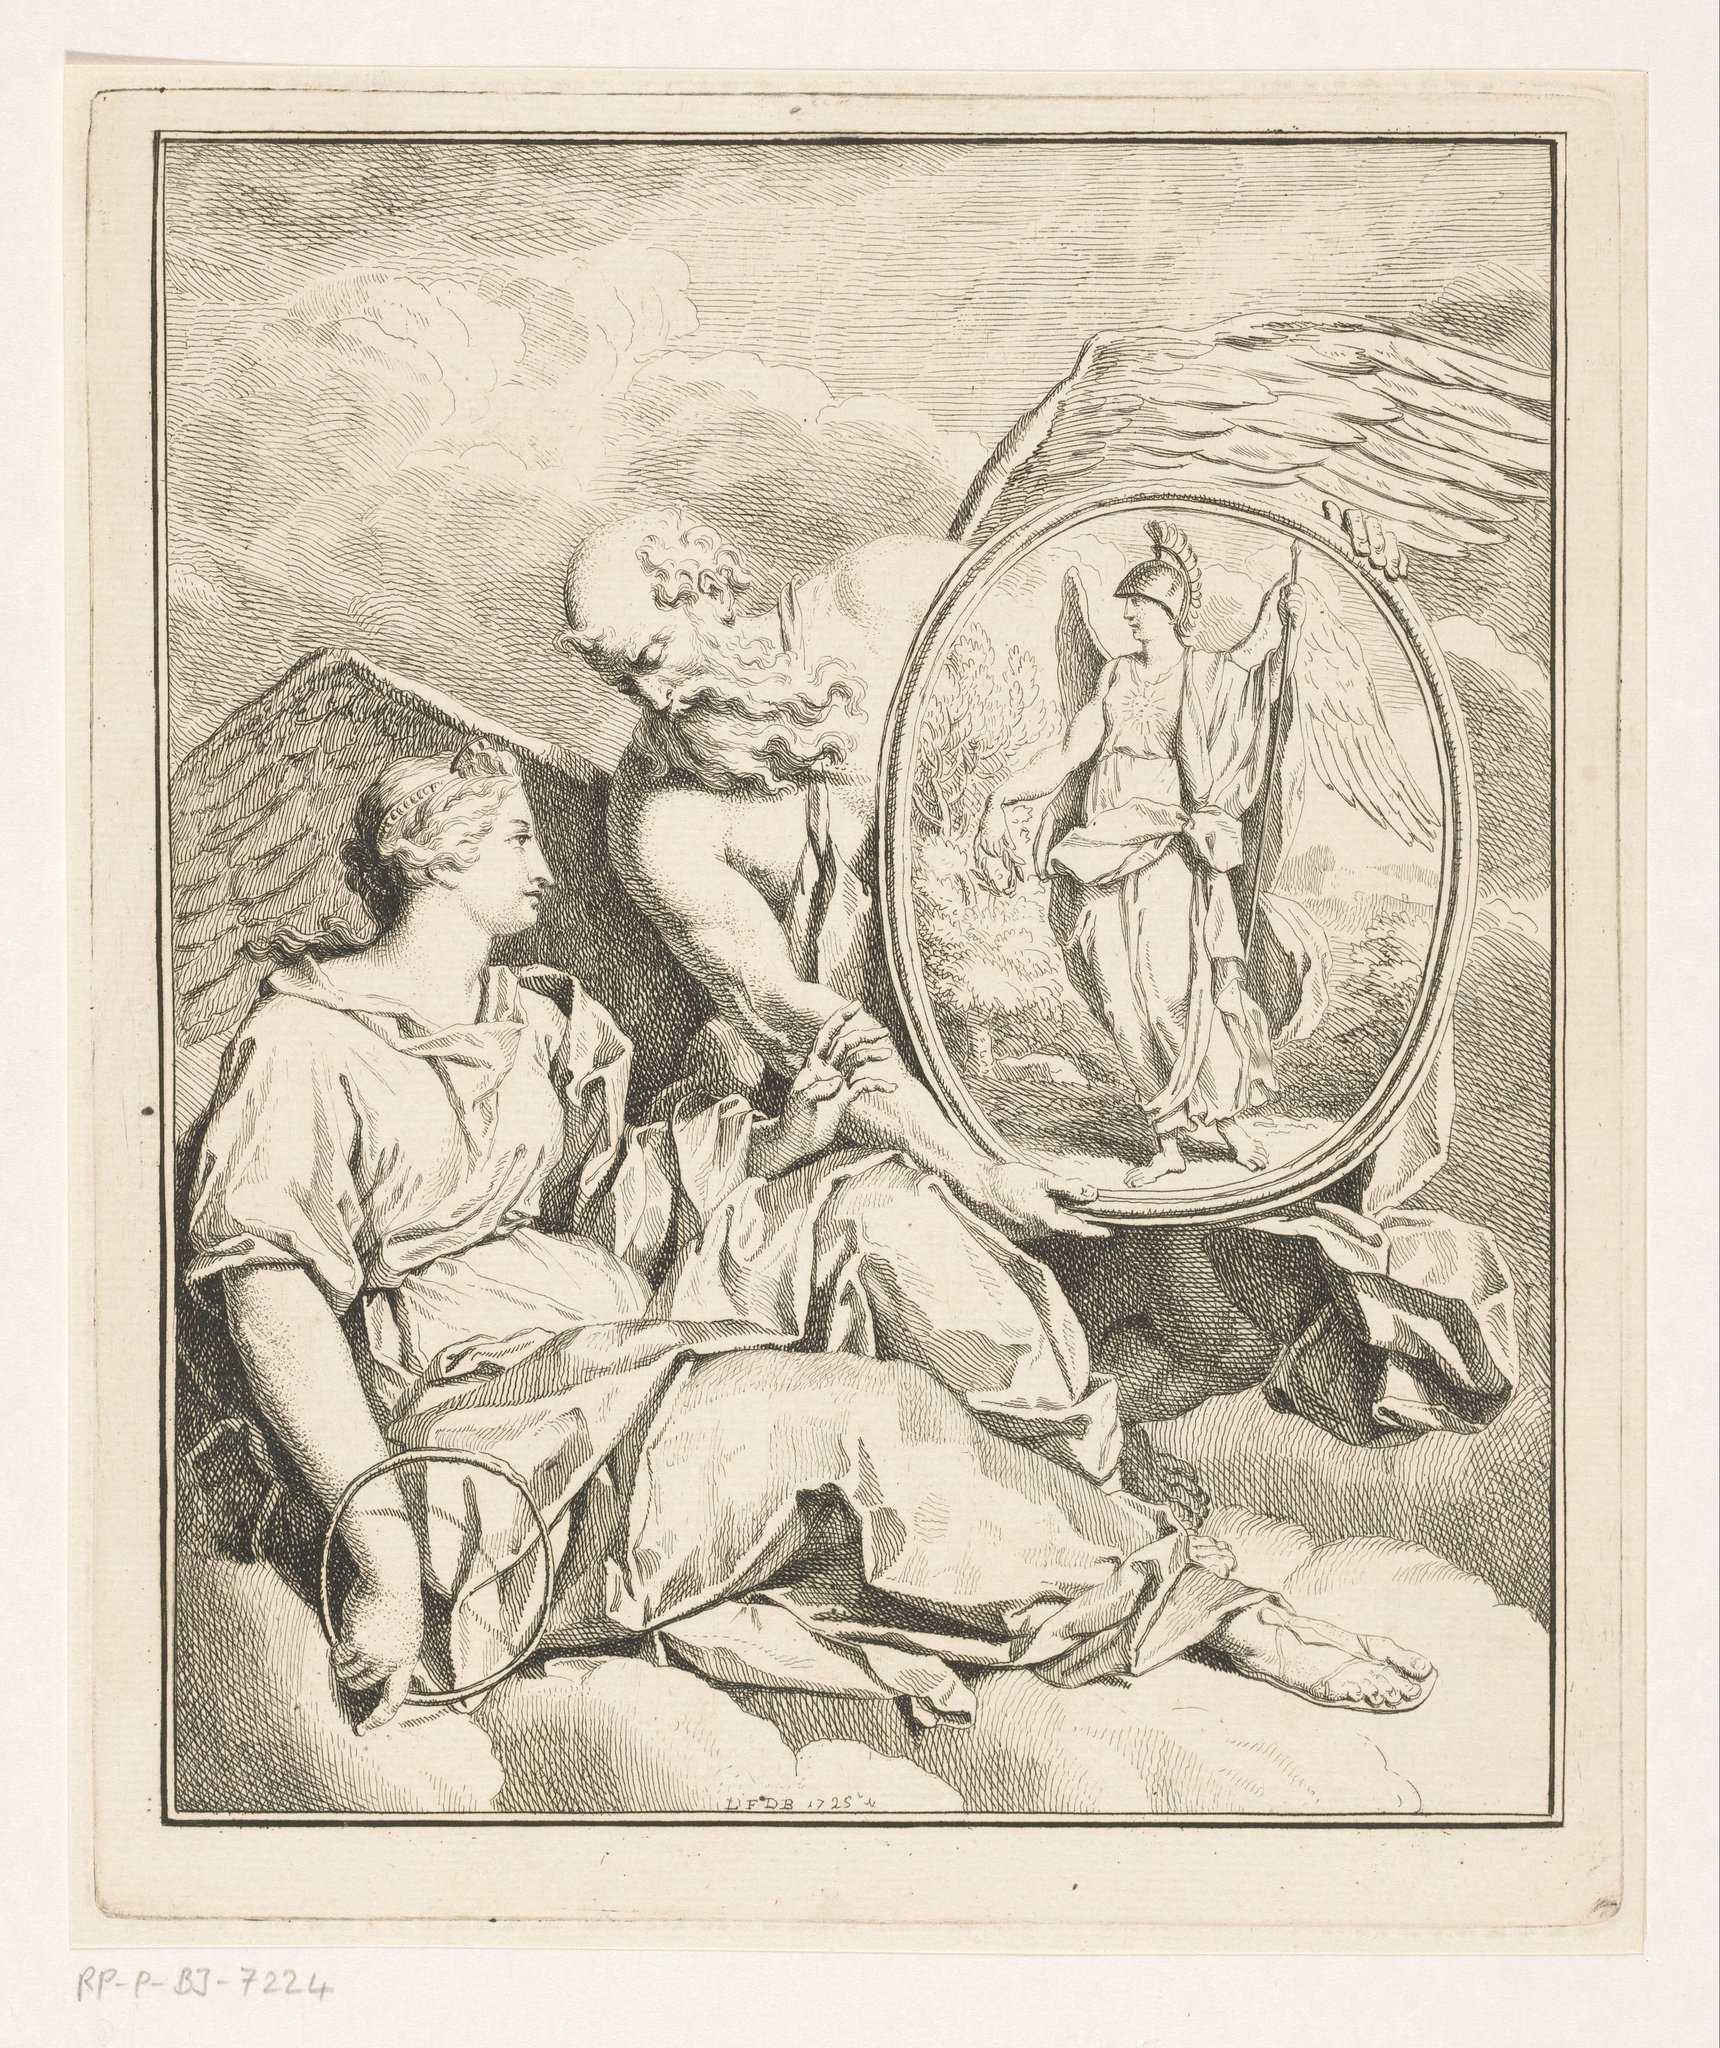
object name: print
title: Allegorische voorstelling met Vader Tijd die de personificatie van de eeuwigheid een plaquette van Minerva toont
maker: louis fabritius dubourg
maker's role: draughtsman, print maker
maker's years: 1693-1775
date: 1725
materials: paper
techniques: etching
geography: amsterdam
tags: (story of) minerva (pallas, athena), eternity, 'aeternitas'; 'eternità','eternità o perpetuità' (ripa), serpent ouroboros, father time, man with wings and scythe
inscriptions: collector's mark: Lugt 240